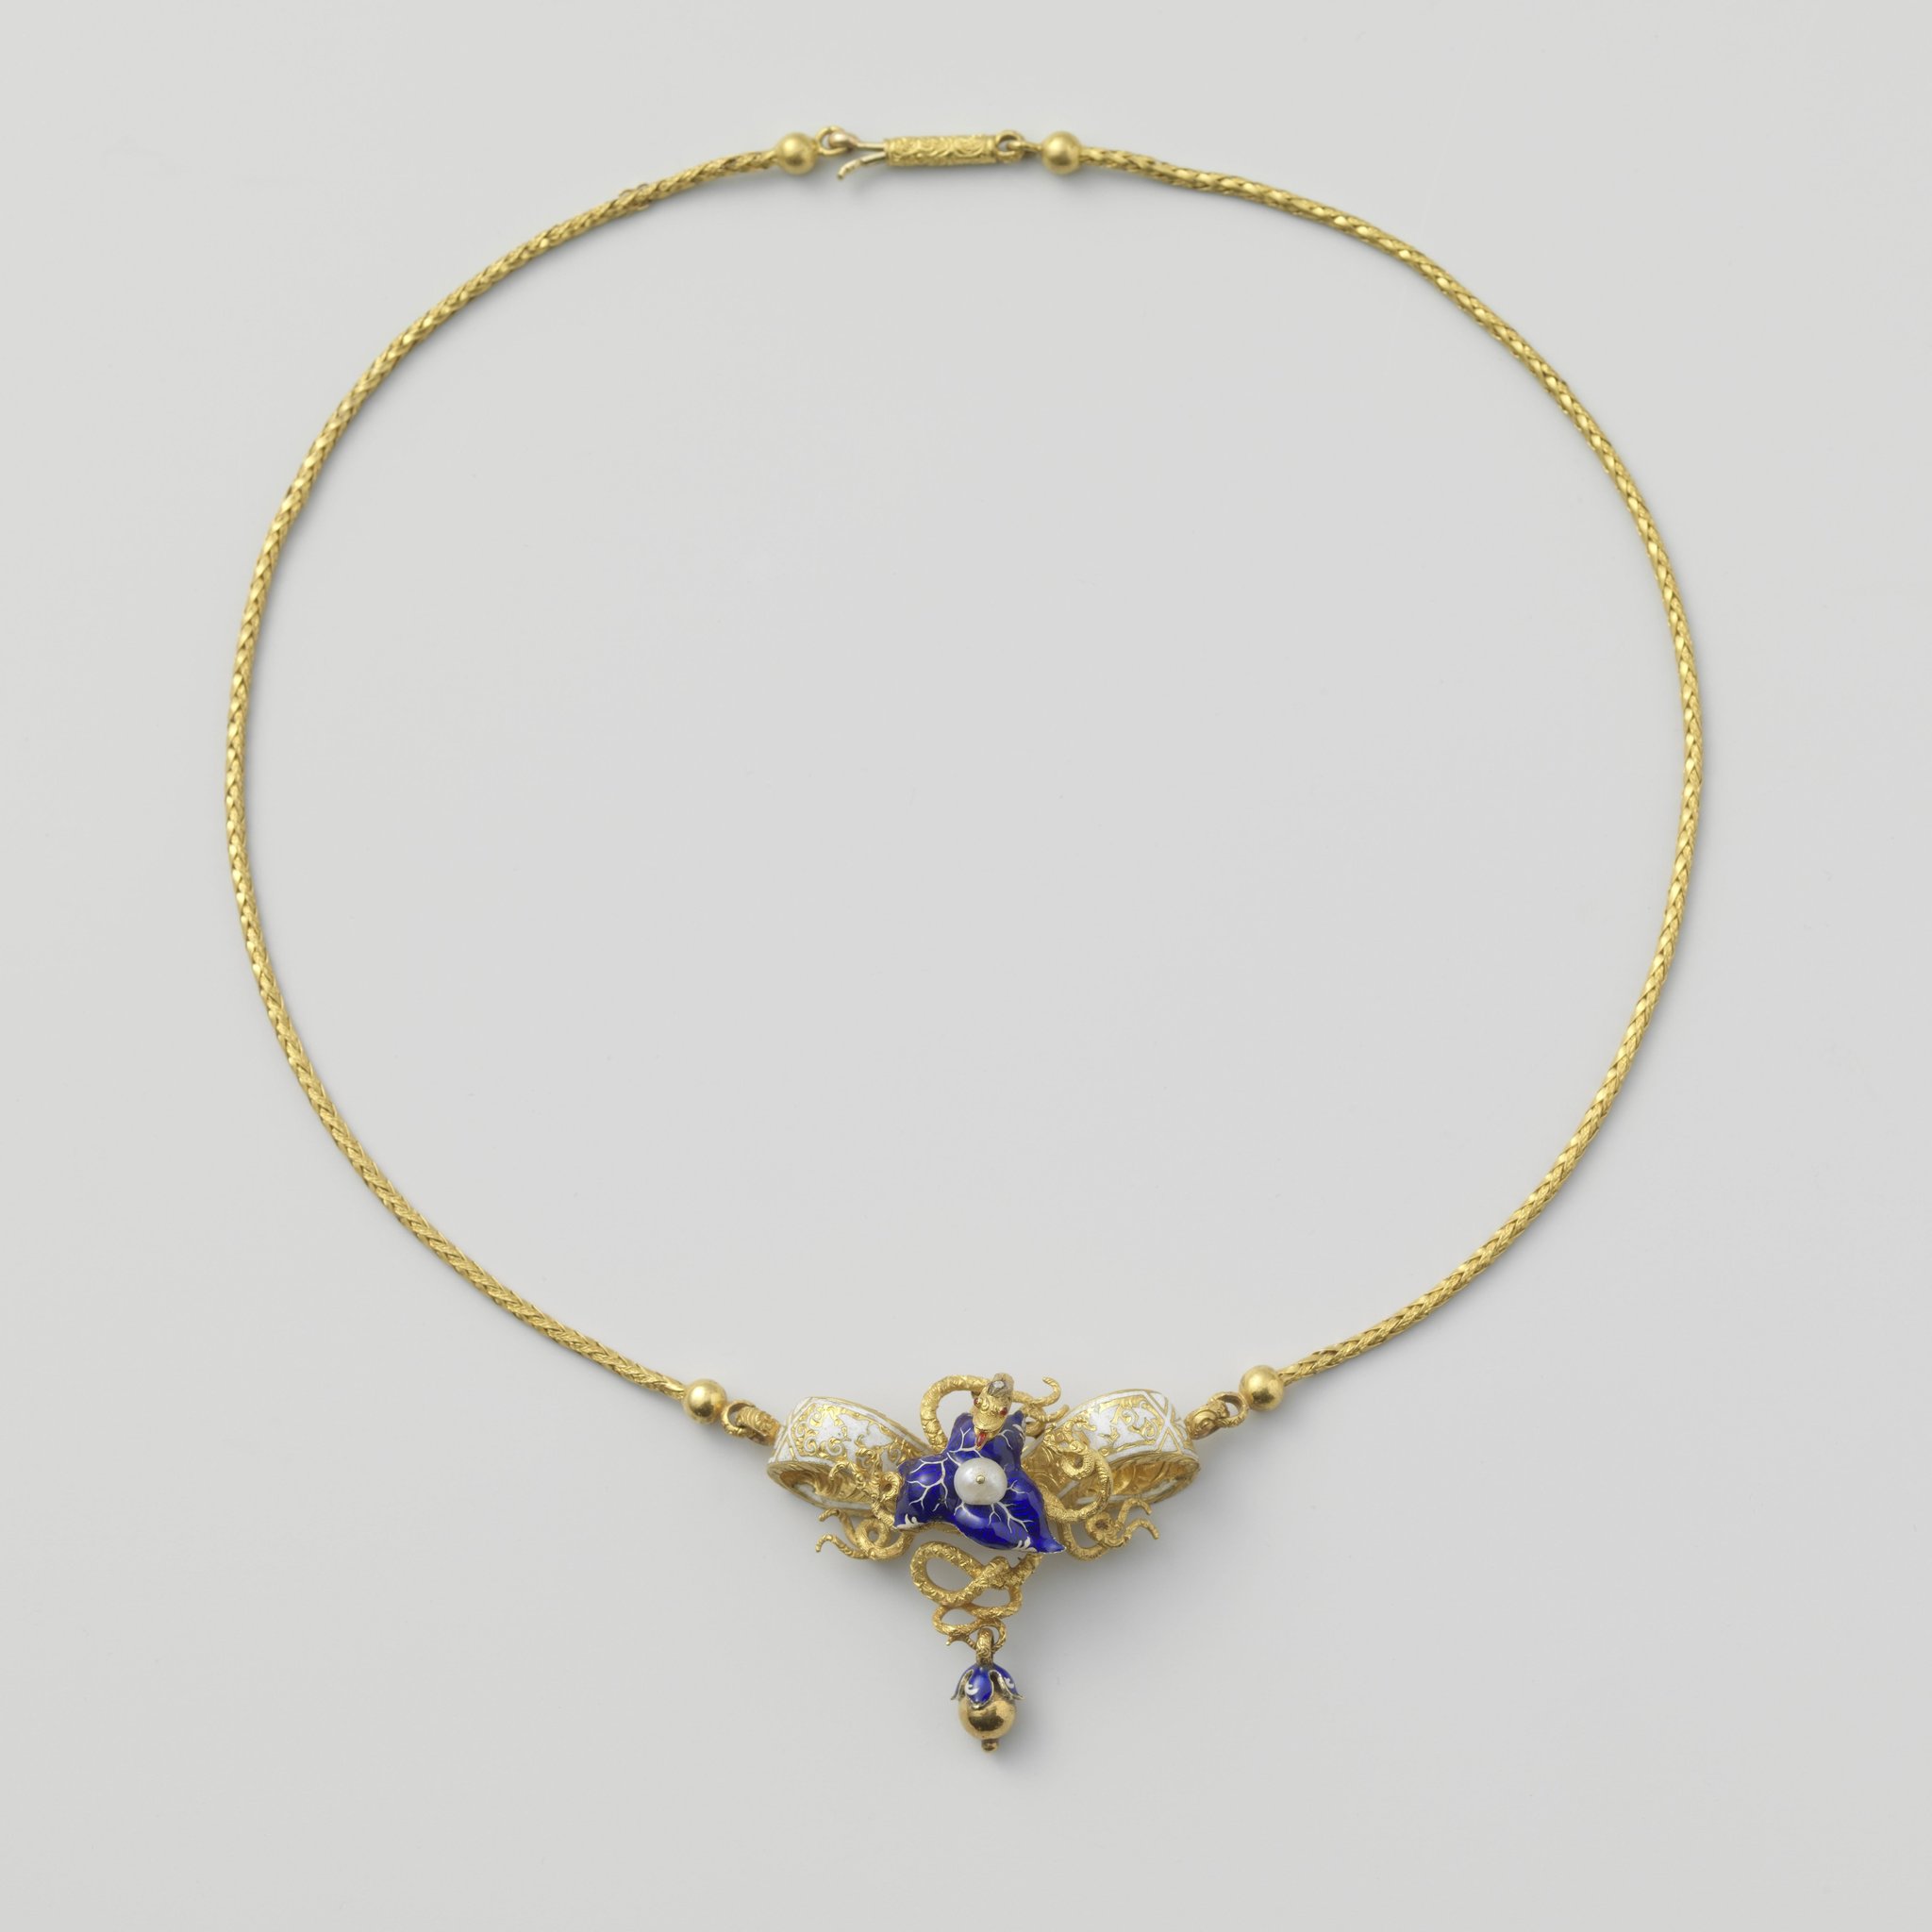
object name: jewellery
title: Collier, deel van een demi-parure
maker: Anonymous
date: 1840-1849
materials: diamond, gold, pearl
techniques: enameling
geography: germany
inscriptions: mark: ‘IL (?) in rechthoek’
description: Parure. Gold, diamonds, pearls and enamel. Germany (?), c. 1840 - 1850.